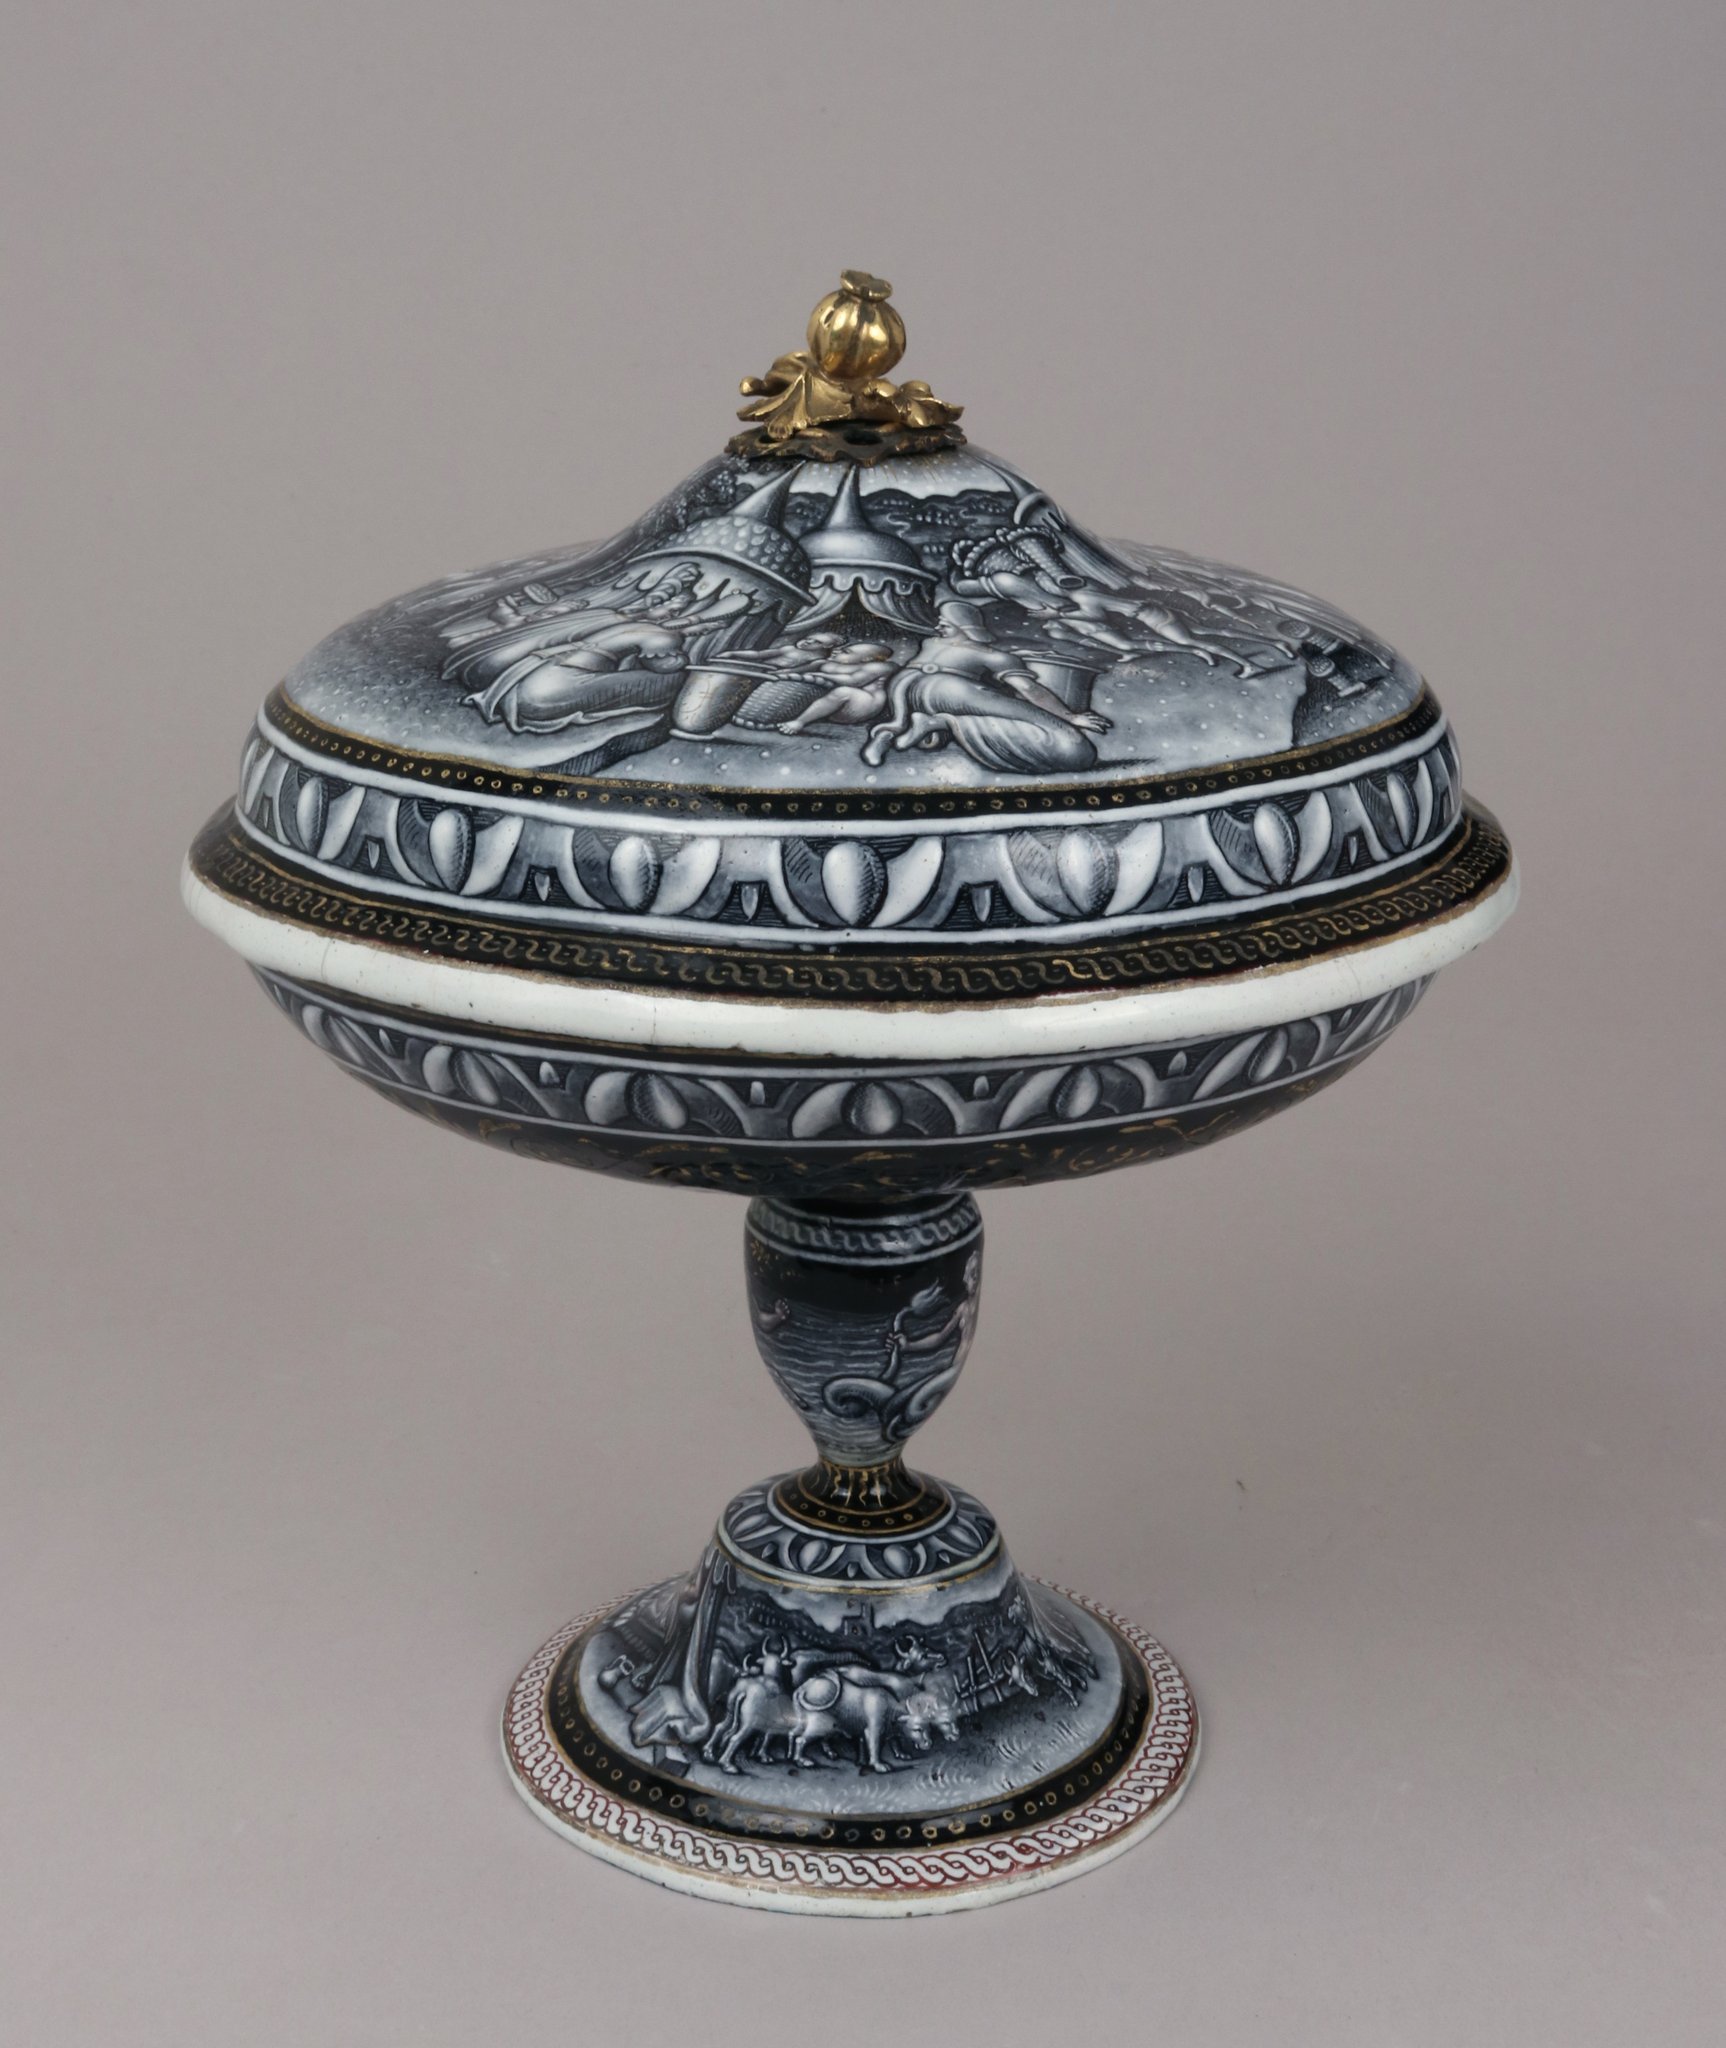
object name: tazza with cover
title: Scenes from the Life of Joseph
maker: pierre reymond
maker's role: artist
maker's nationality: french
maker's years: 1513-1590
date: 1534-1566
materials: copper, enamel, gilt, metal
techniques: gilding, painting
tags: tents,men